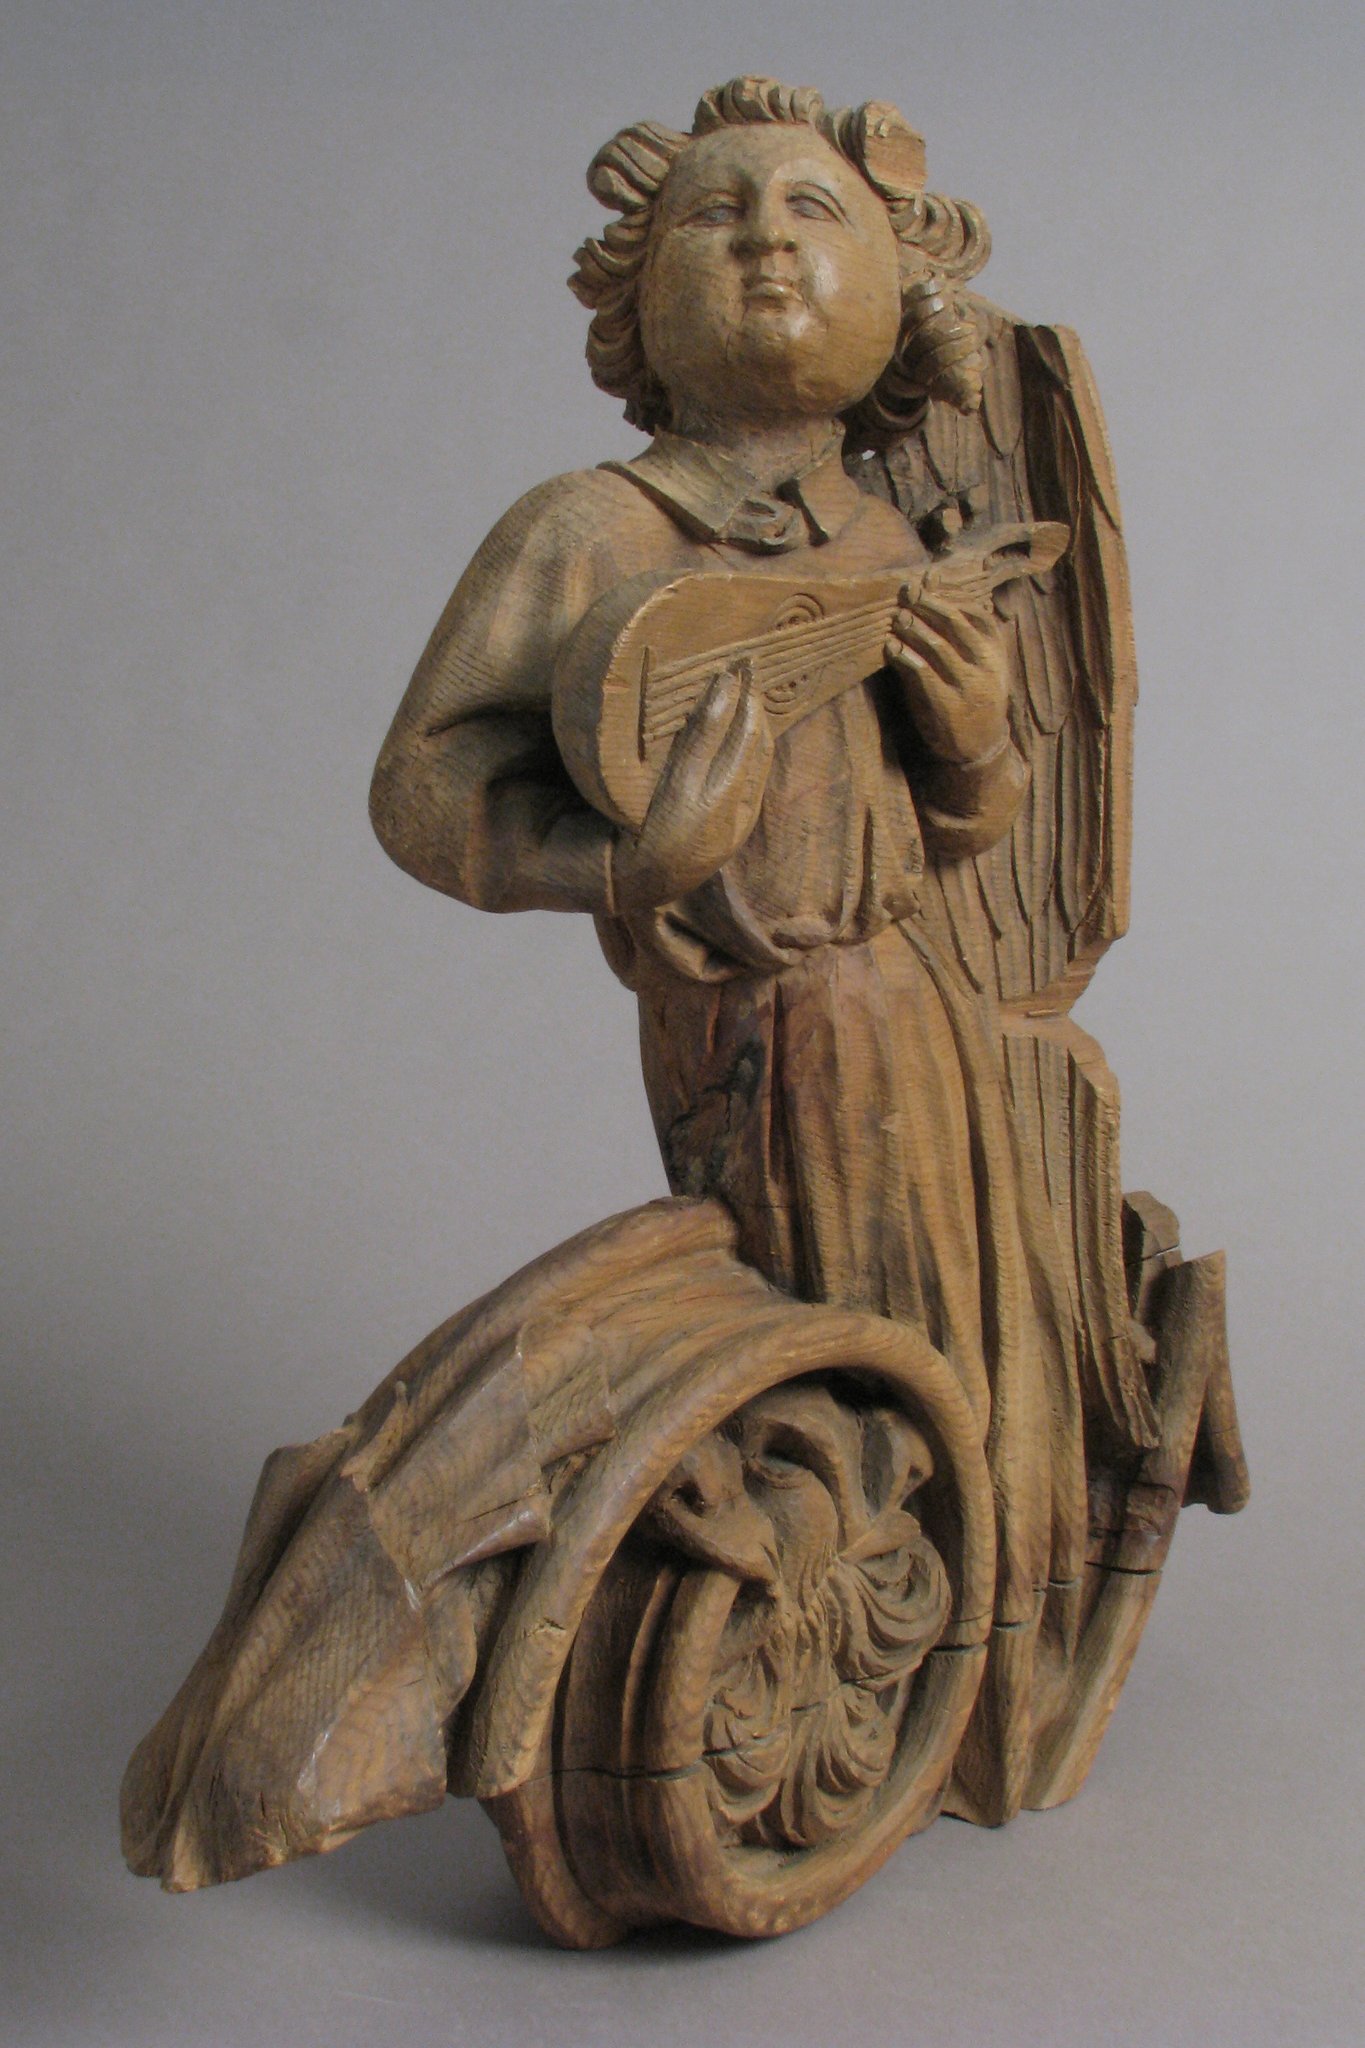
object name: choir stall fragment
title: Musical Angel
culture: french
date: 1450-1500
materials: wood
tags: musical instruments,angels